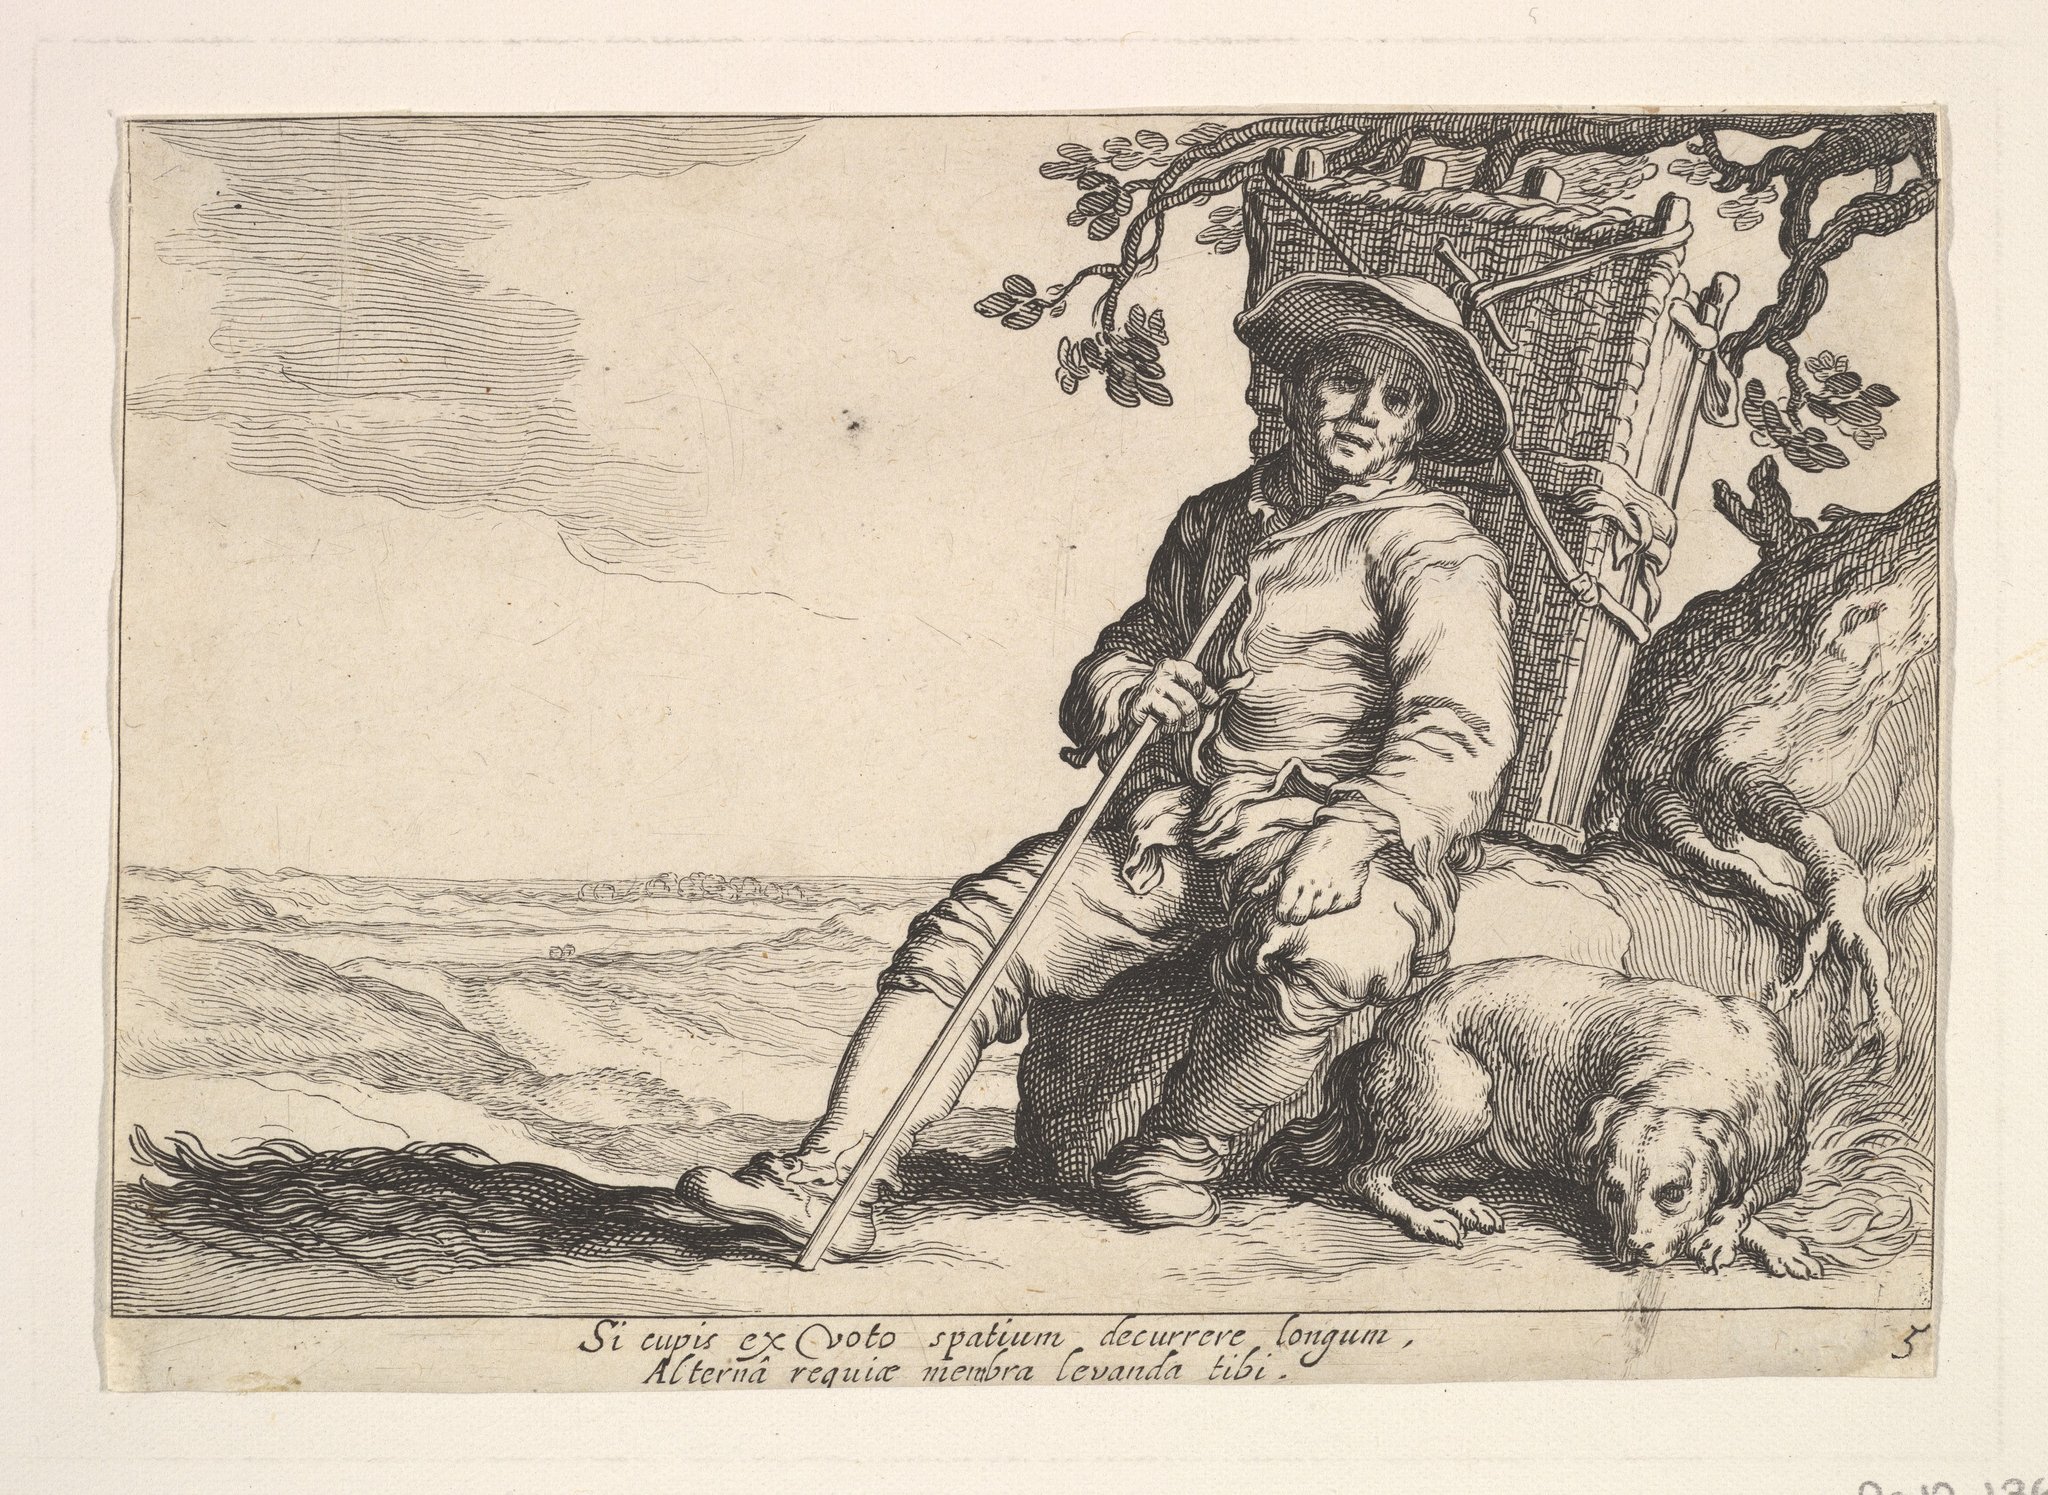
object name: print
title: Pleasures of Occupation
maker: cornelis bloemaert (ii)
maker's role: artist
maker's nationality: dutch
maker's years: 1603-1684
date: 1610-1684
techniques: engraving, etching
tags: men,dogs